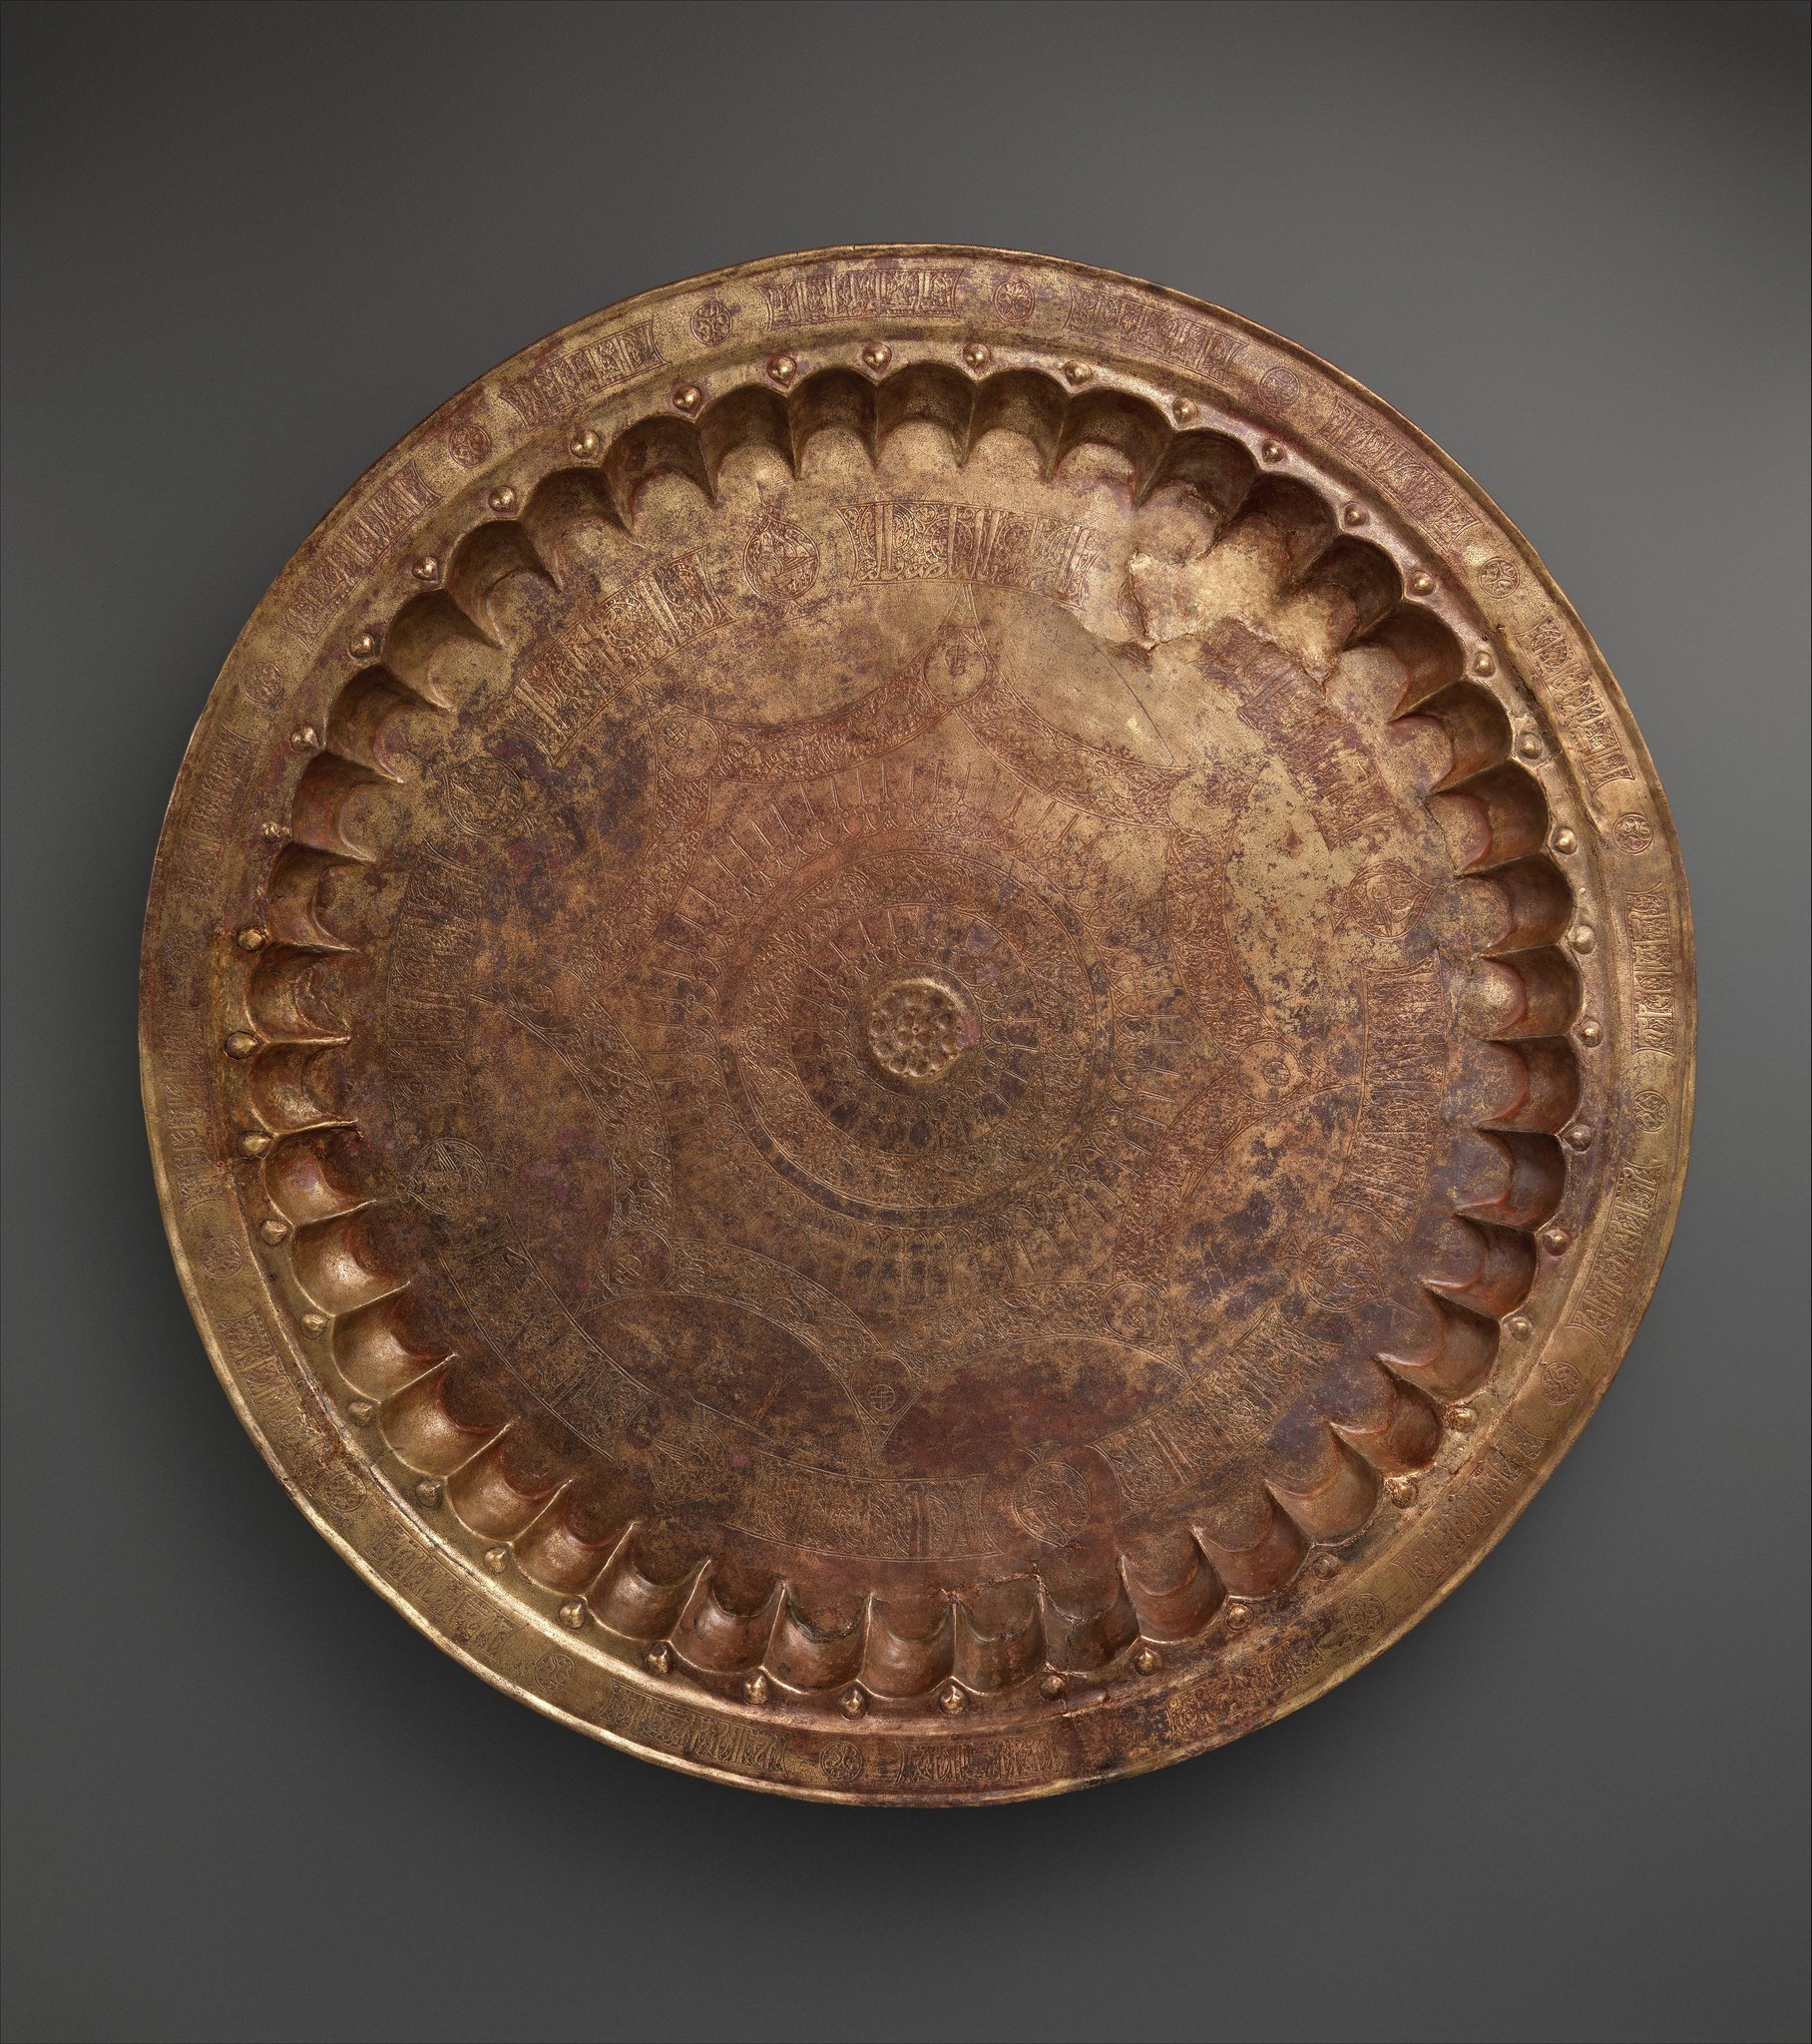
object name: tray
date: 1101-1200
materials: bronze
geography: iran